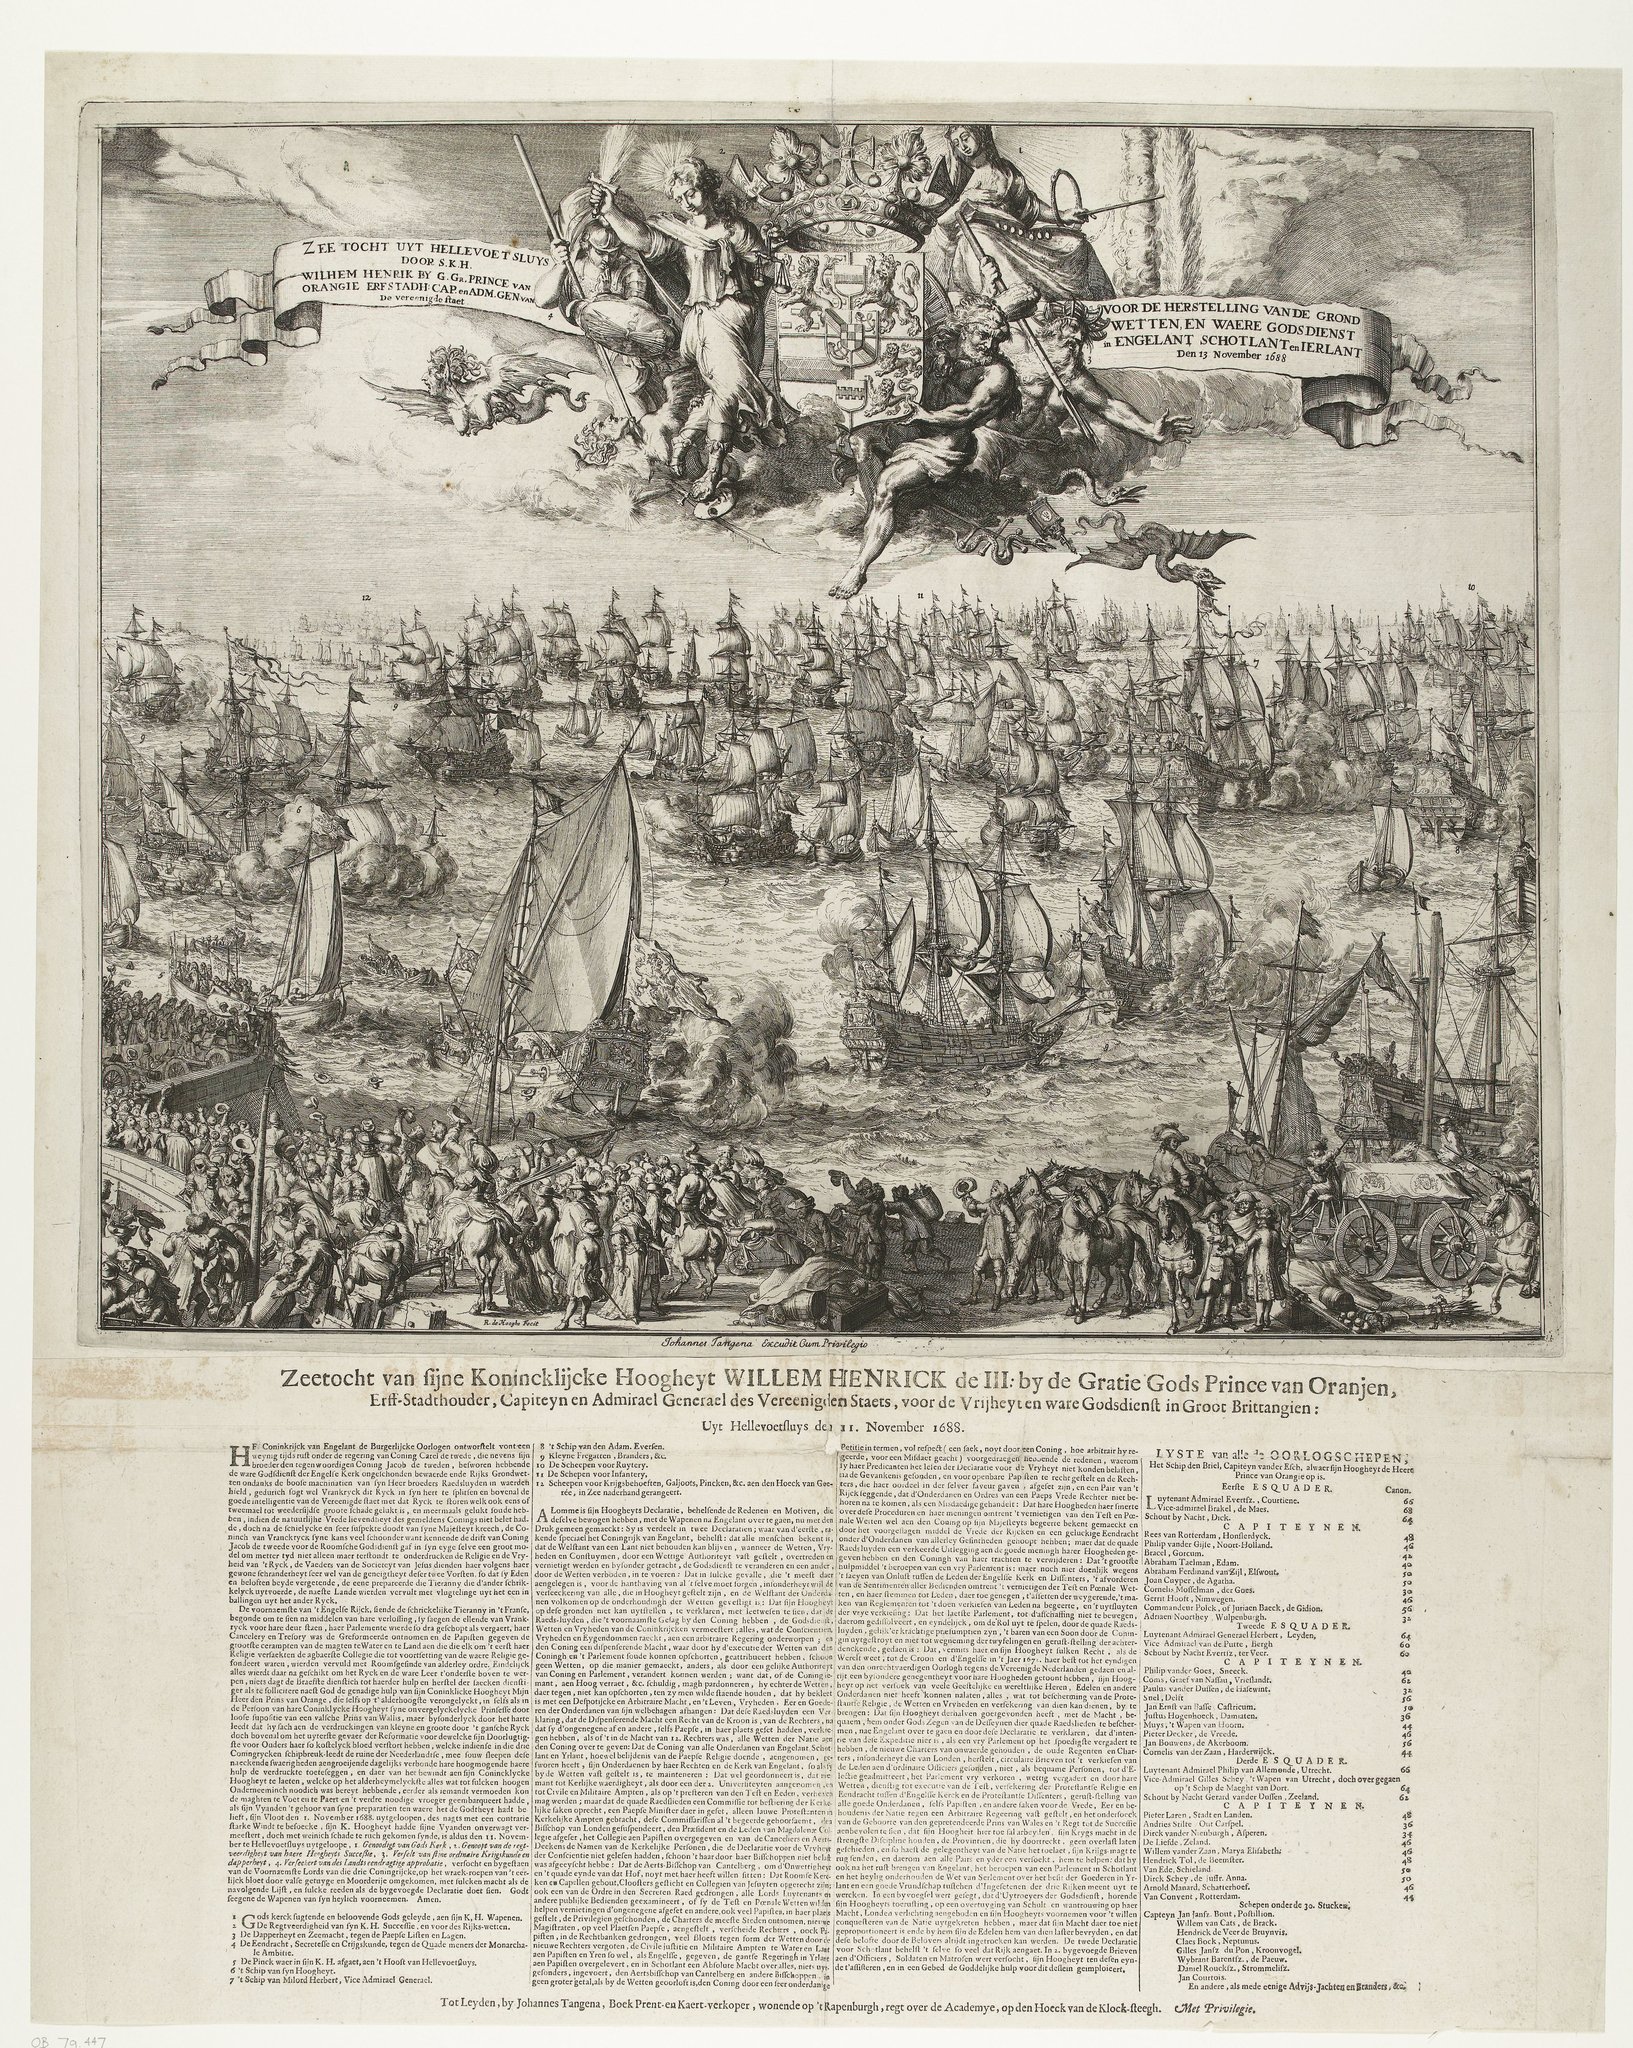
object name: print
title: Zeetocht van sijne Konincklijcke Hoogheyt Willem Henrick de III; by de Gratie Gods Prince van Oranjen, Erff-Stadthouder, Capiteyn en Admirael Generael der Vereenigden Staets, voor de Vrijheyt en ware Godsdienst in Groot-Brittangien: Uyt Hellevoetsluys den 11. November 1688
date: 1688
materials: paper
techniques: etching, letterpress printing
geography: leiden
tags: william iii (prince of orange and king of england, scotland, and ireland), review, inspection (of company, unit, troop) (+ naval force), hellevoetsluis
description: Vlootschouw bij het vertrek van Willem III vanuit Hellevoetsluis naar Engeland, 11 november 1688. Een menigte mensen op de kade zwaait de prins uit die in een pink naar het schip zeilt dat hem naar Engeland zal brengen. Bovenaan het wapen van de prins omgeven door allerlei allegorische figuren. Vastgeplakt onder de prent een tekstblad met een beschrijving van de gebeurtenissen, de legenda van de cijfers 1-12 en een lijst van de schepen die deel uit maken van de vloot, in 4 kolommen in het Nederlands.